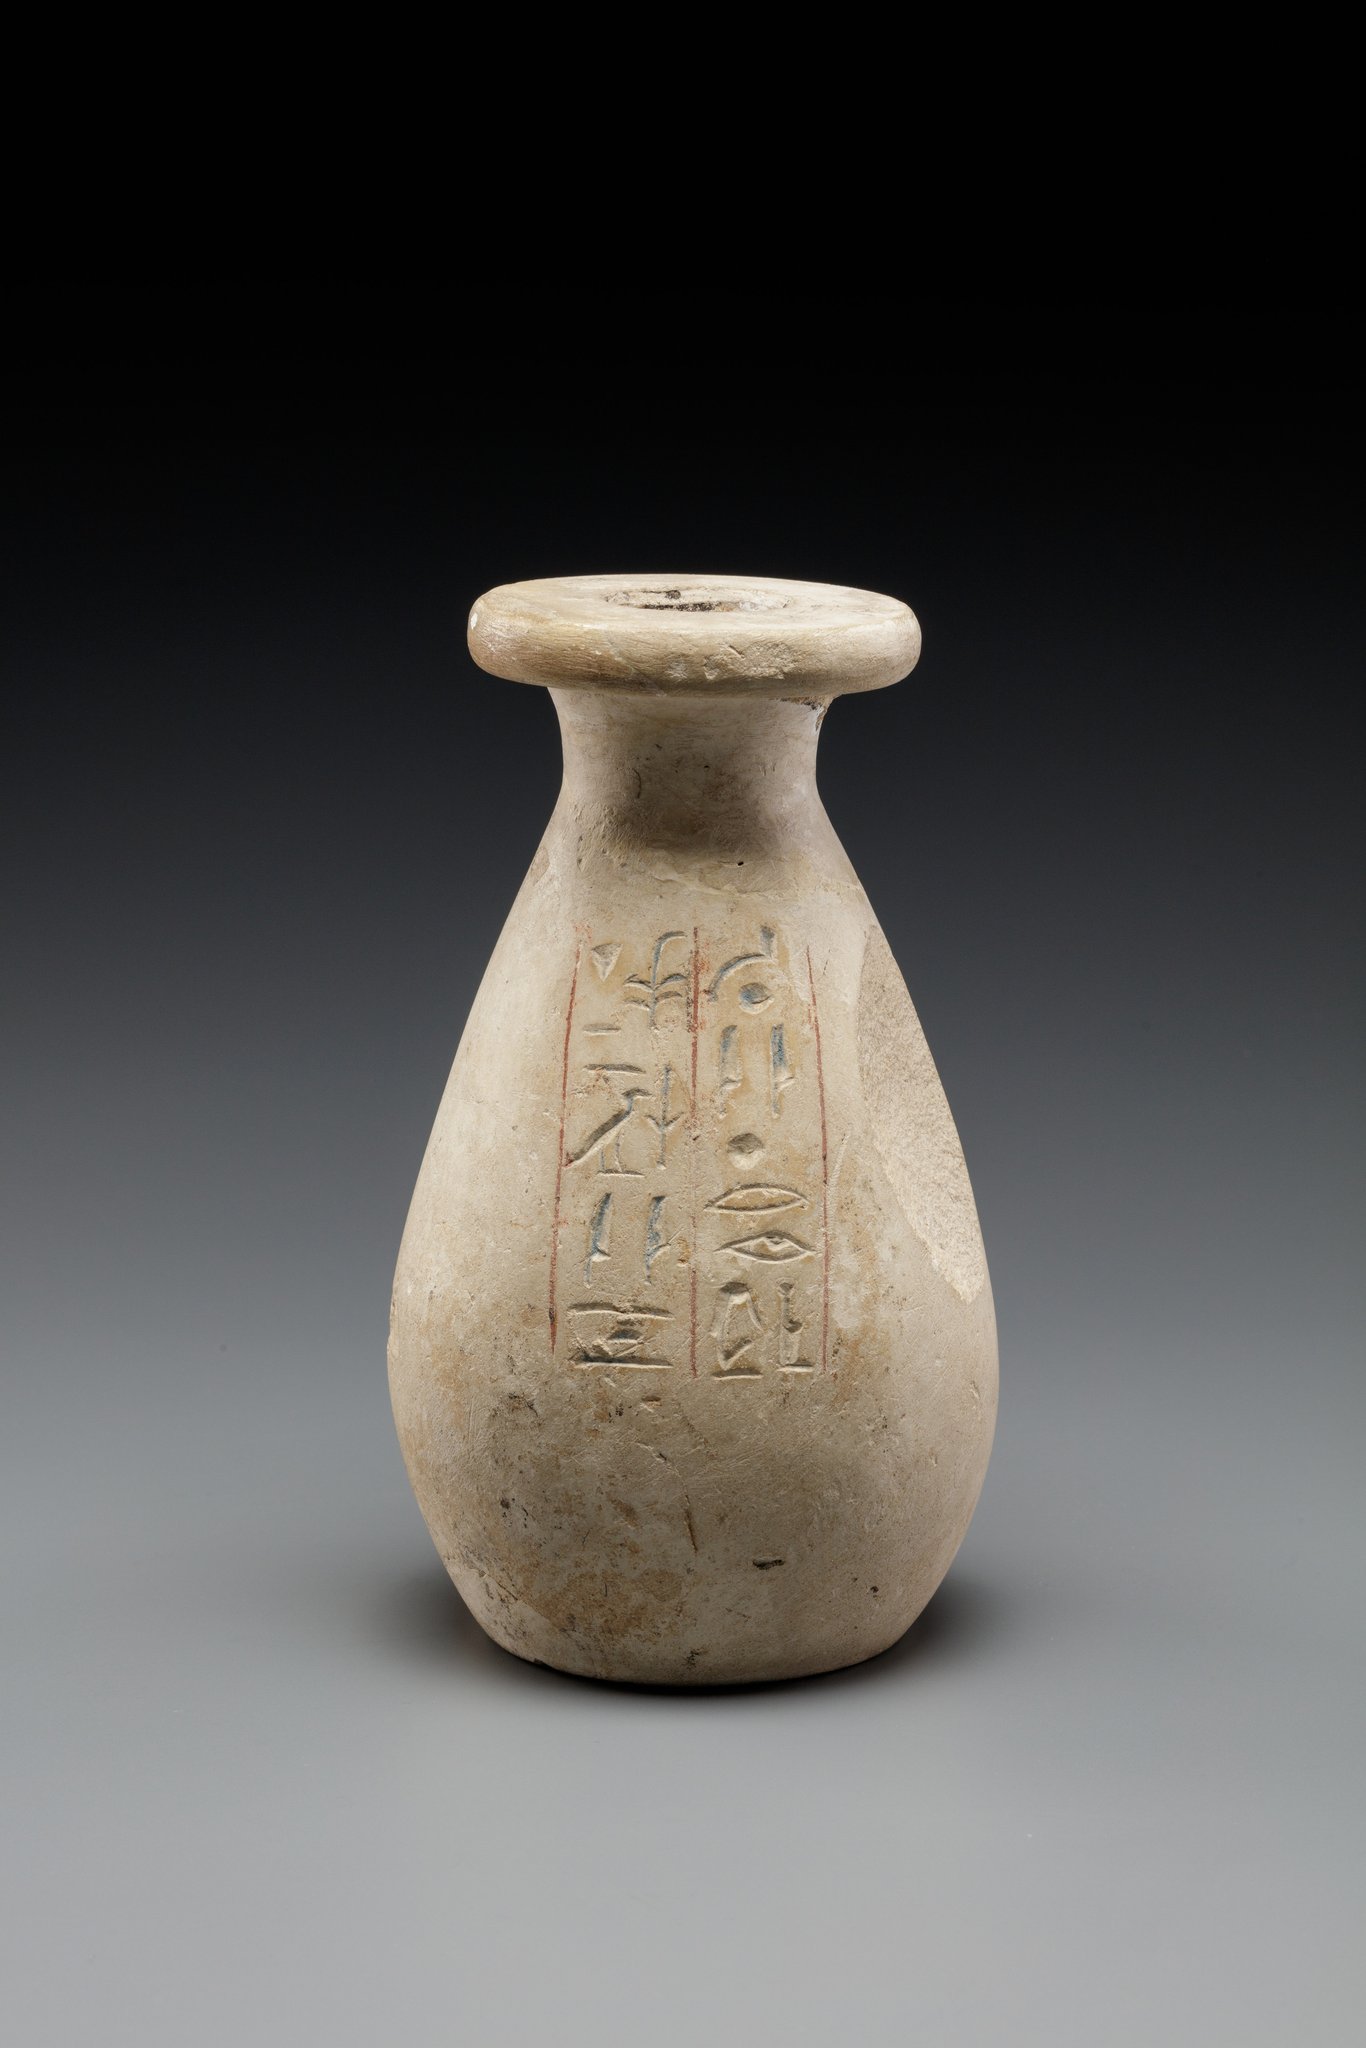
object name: model, jar, senetnay, sennefer, kv 42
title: Dummy Jar Inscribed for Sennefer and Senetnay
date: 1427-1400 BCE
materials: limestone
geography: egypt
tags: hieroglyphs